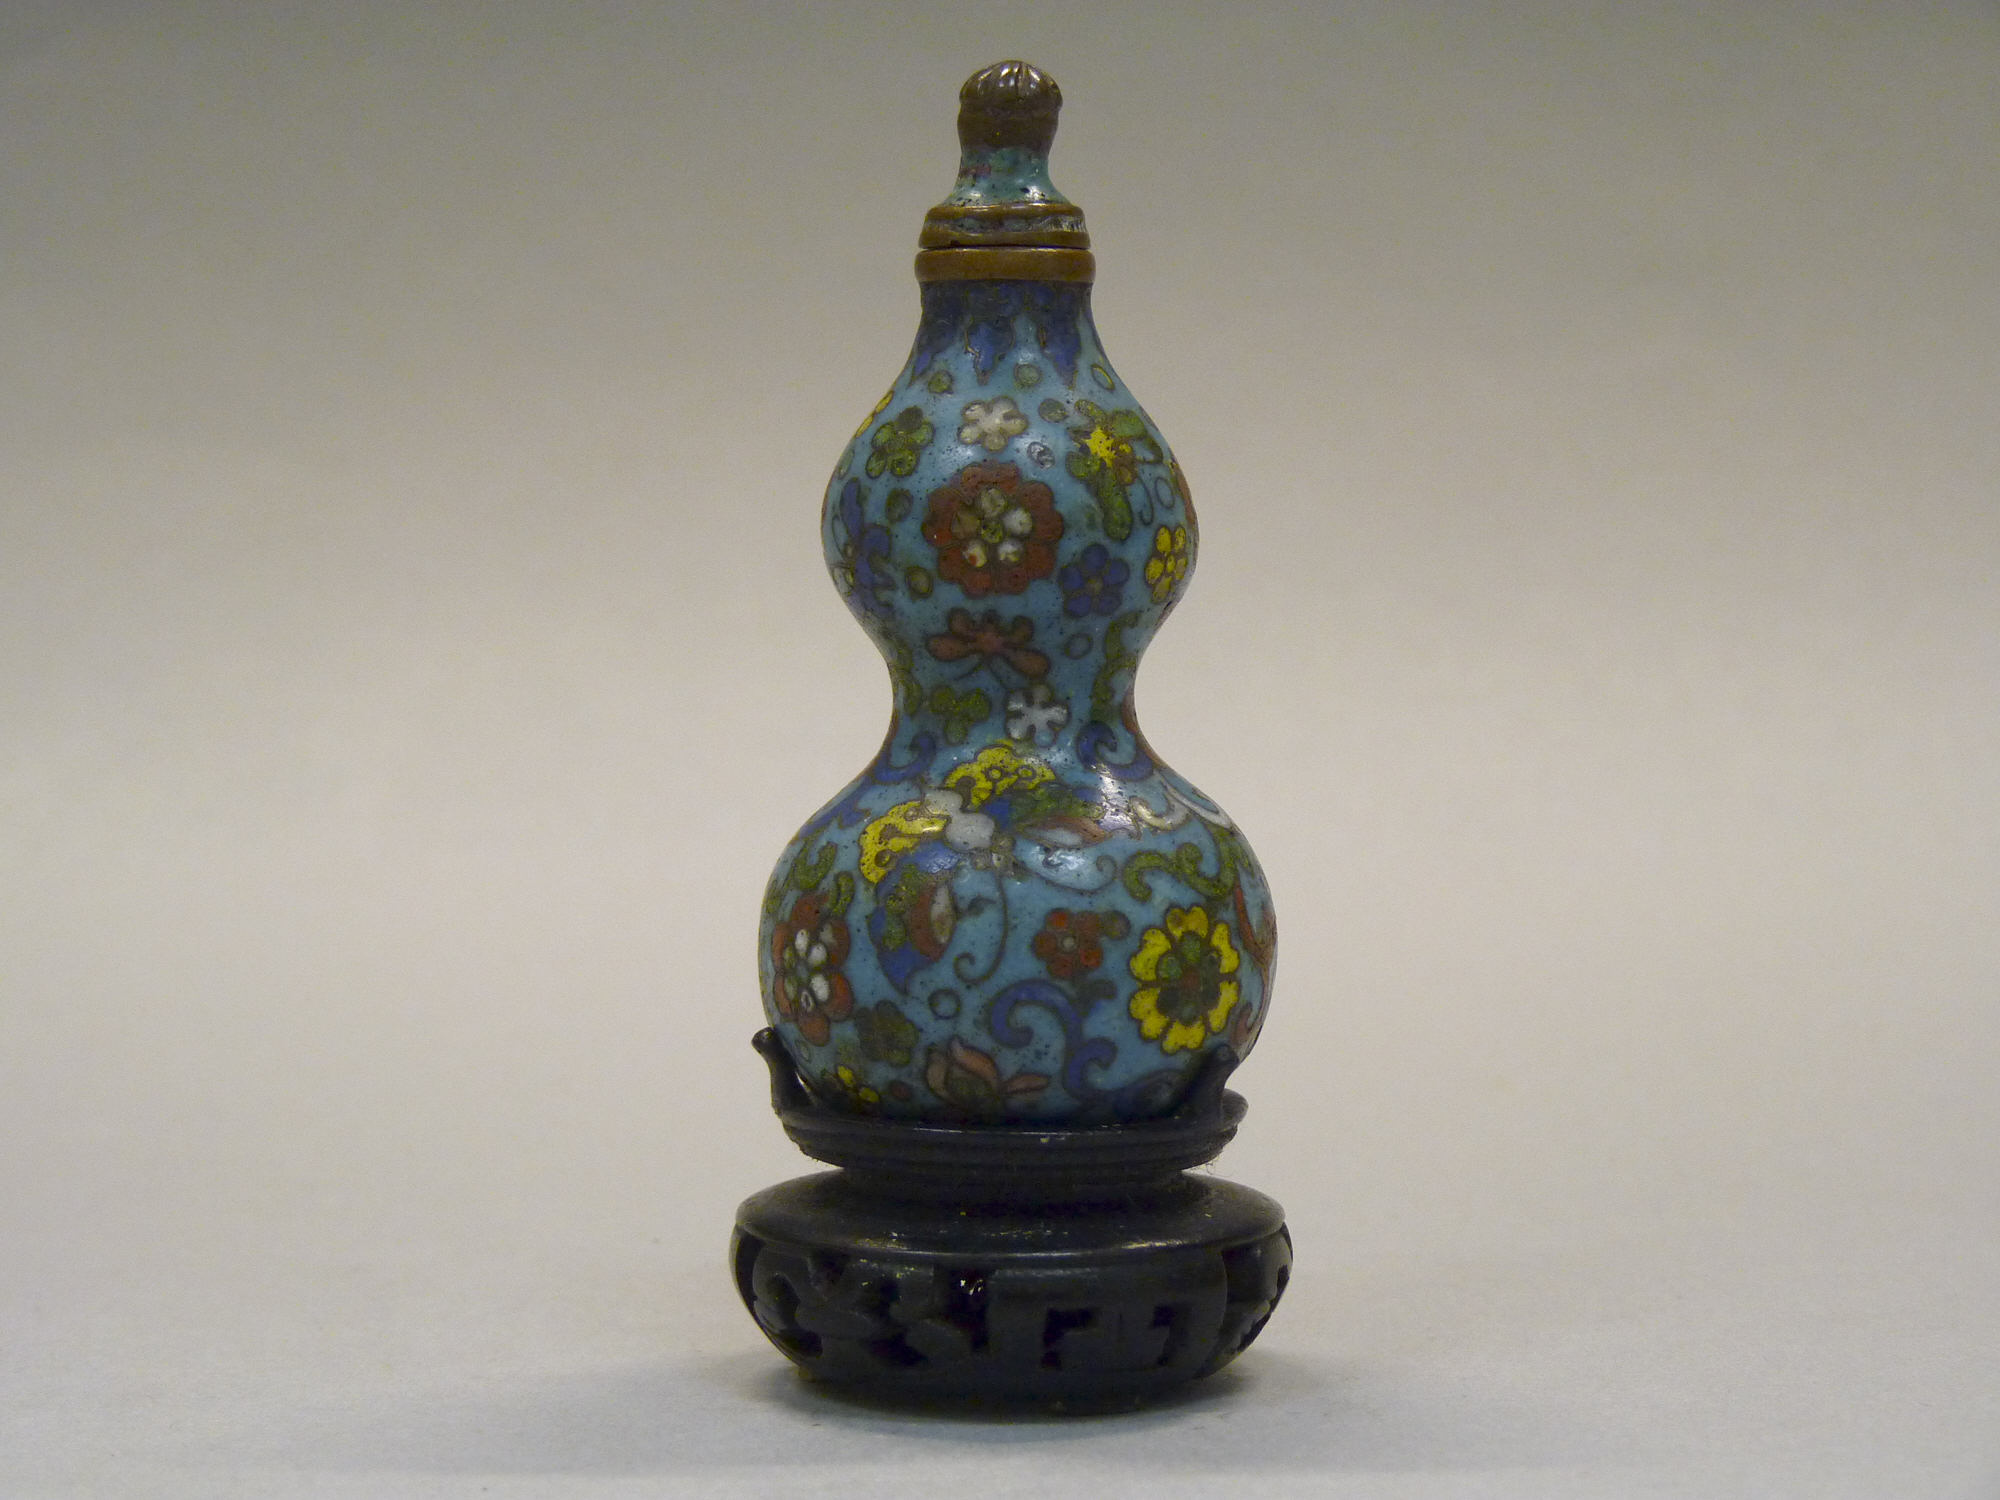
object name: snuff bottle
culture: chinese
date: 1736-1795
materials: enamel, metal, wood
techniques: enamel